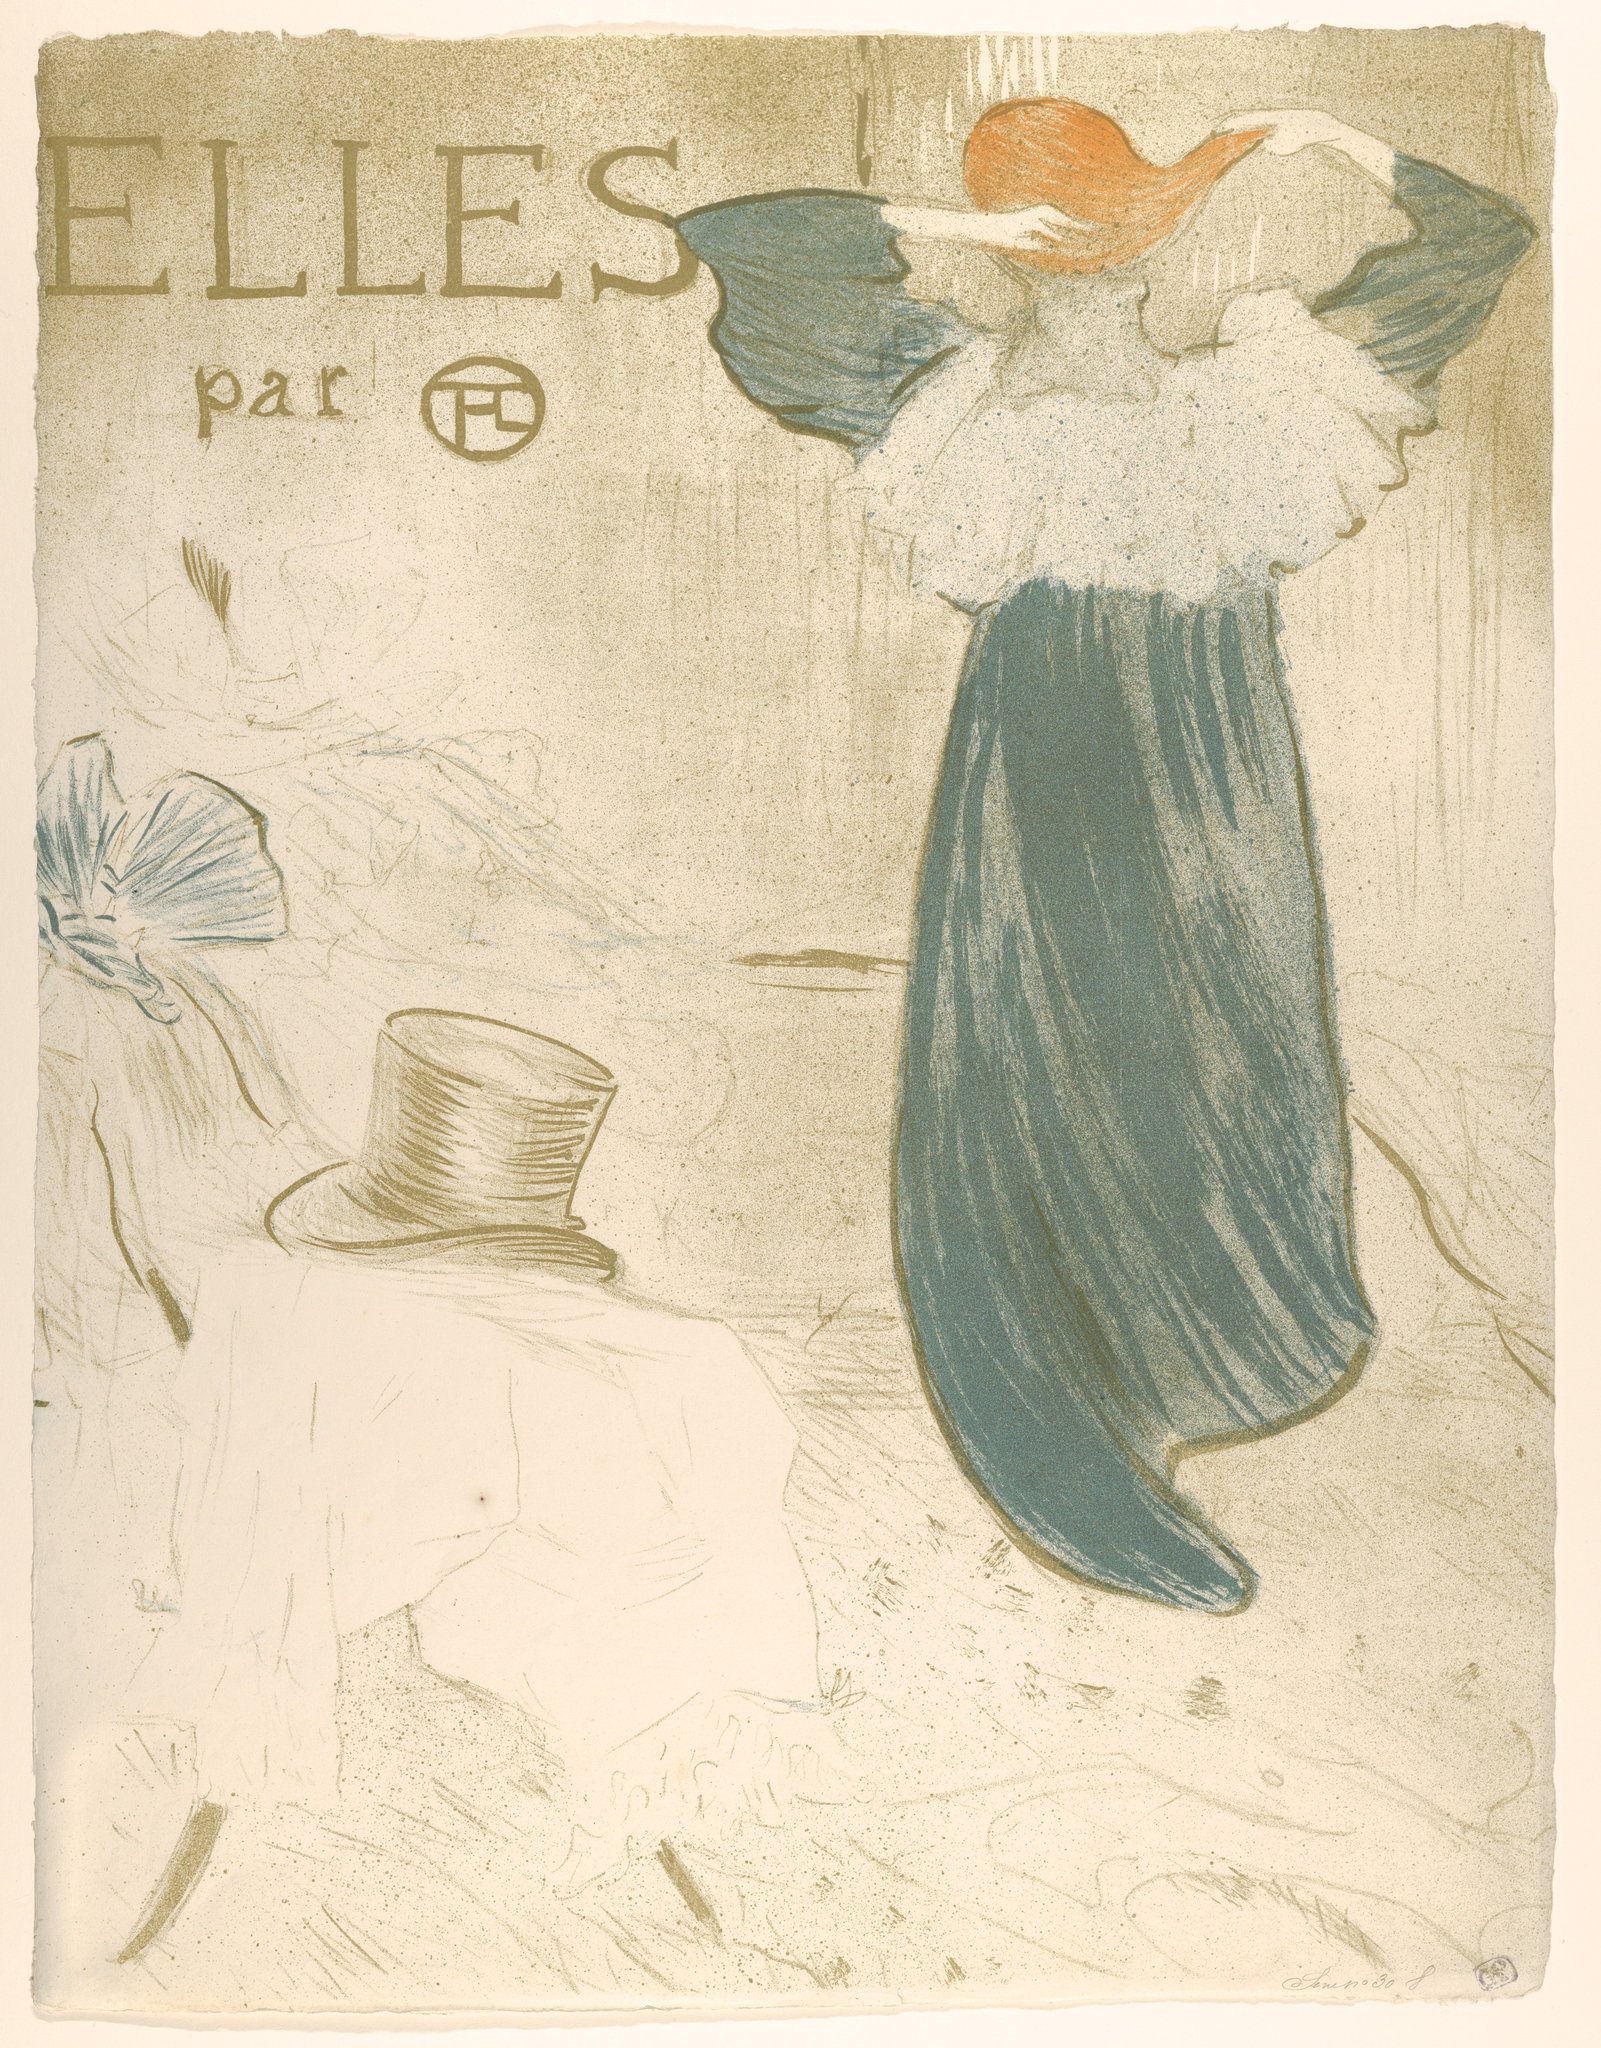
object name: print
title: Elles (portfolio cover)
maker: henri de toulouse-lautrec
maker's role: artist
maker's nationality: french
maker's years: 1864-1901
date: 1896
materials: crayon, paper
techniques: brush, lithograph, printing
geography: france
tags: hats,women